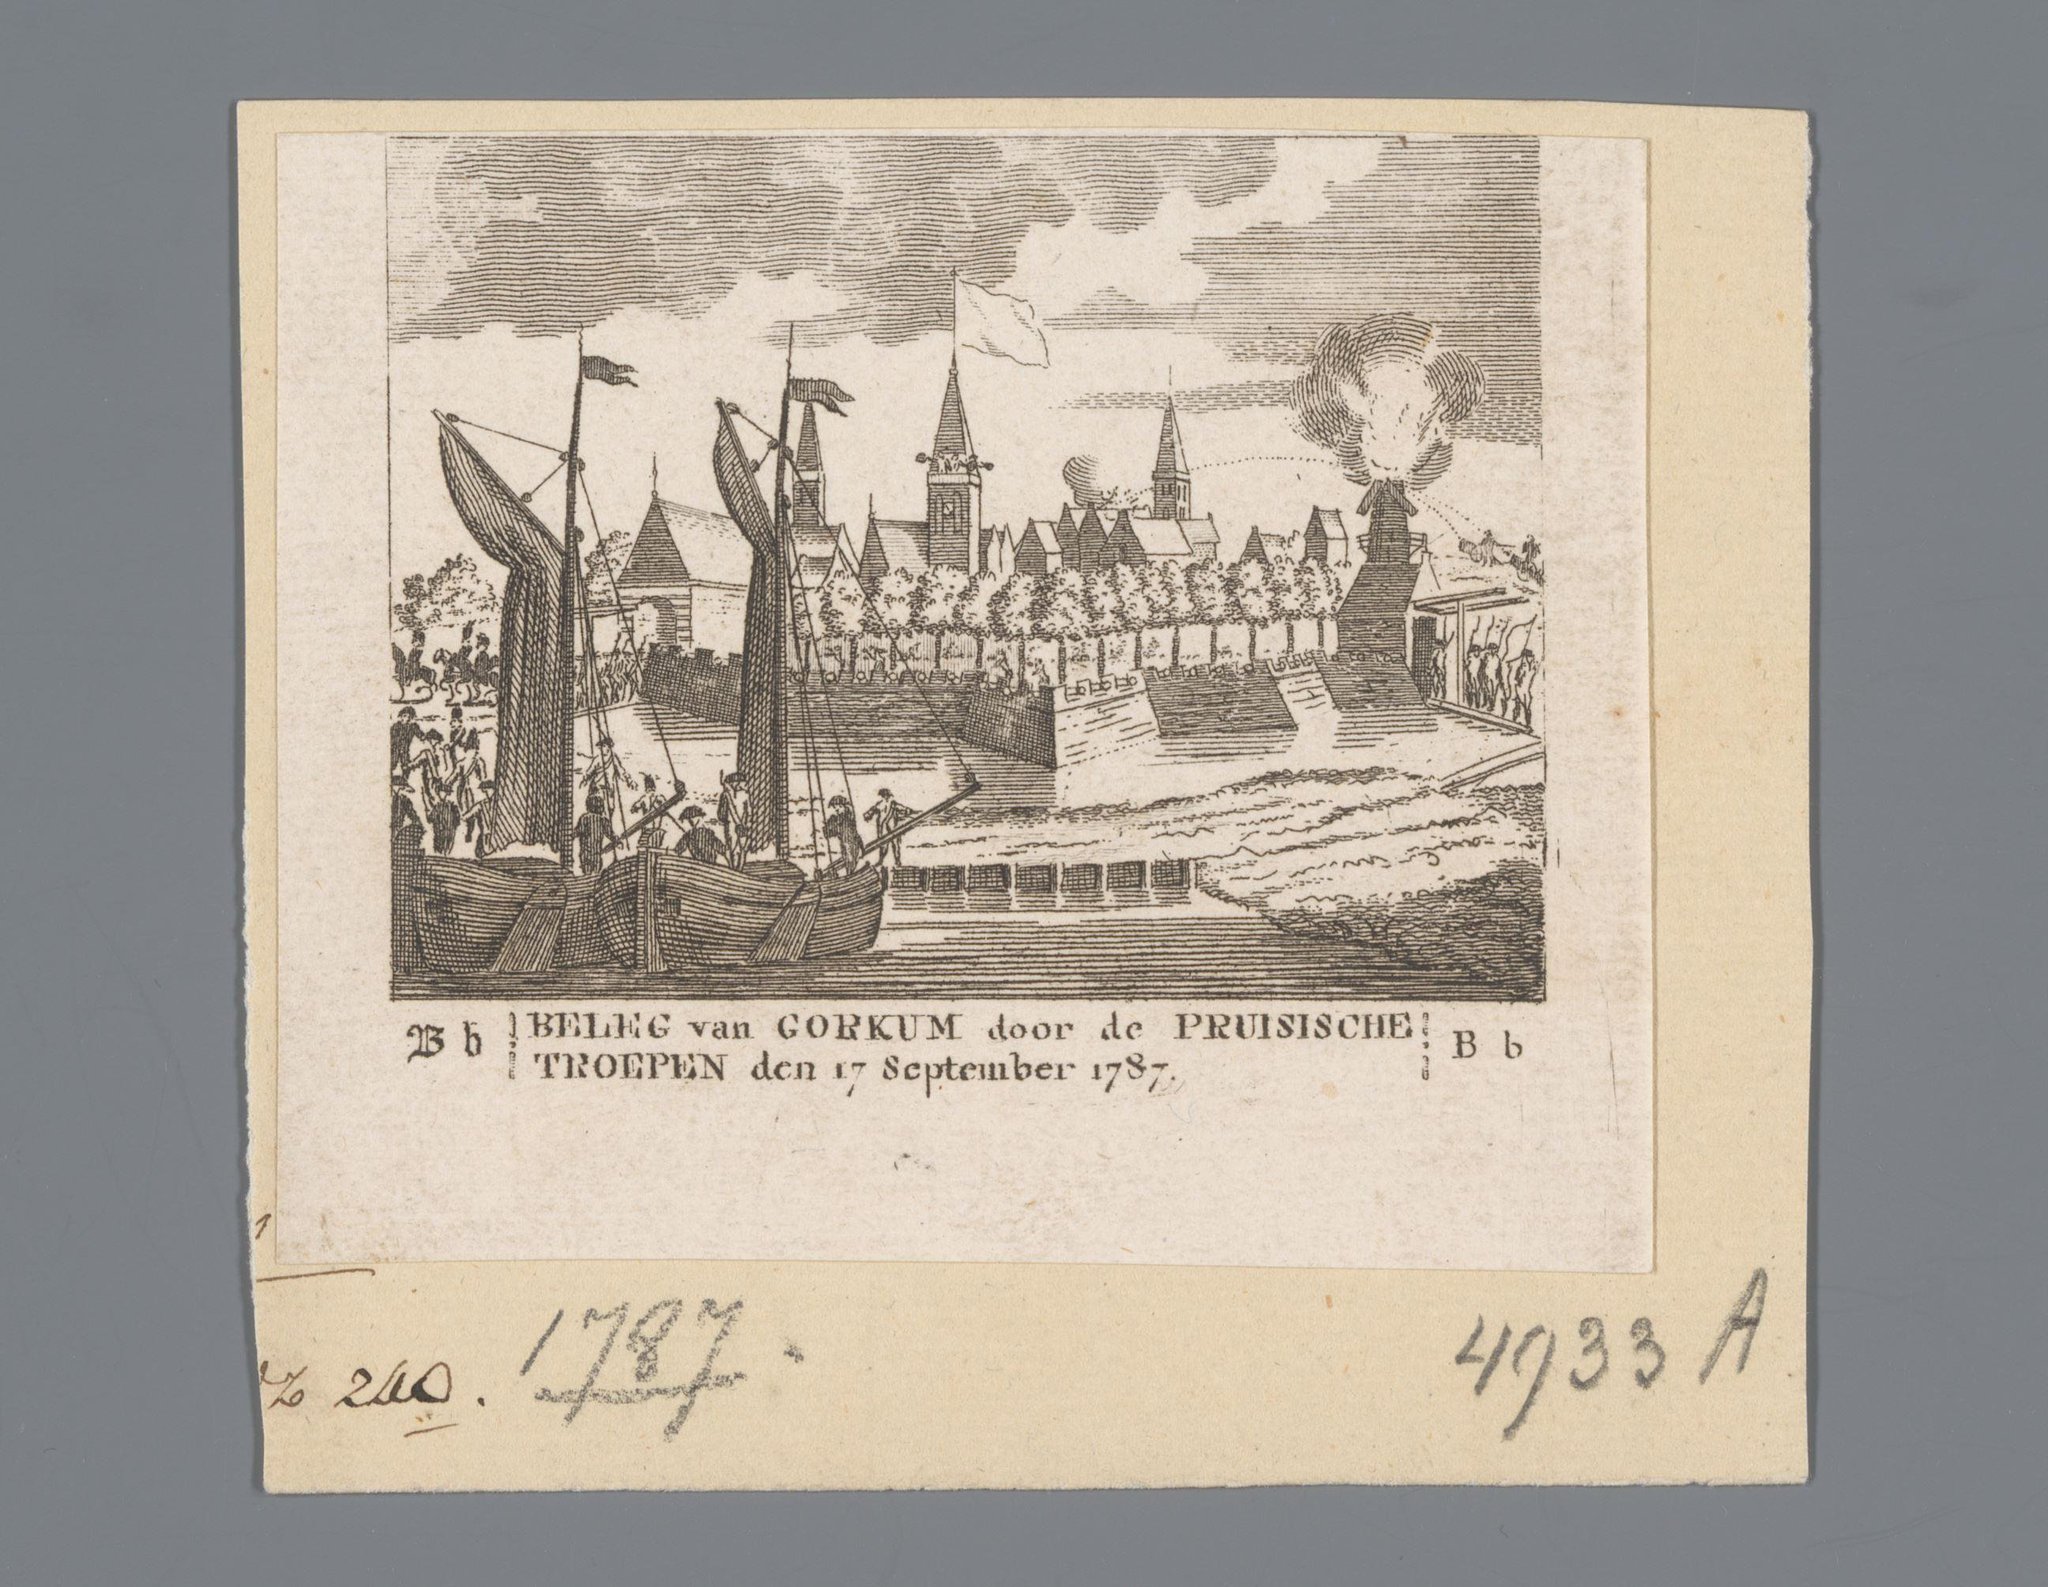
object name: print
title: Beleg van Gorkum door de Pruisische Troepen den 17 September 1787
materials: paper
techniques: etching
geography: amsterdam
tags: putting the enemy to flight - hh - being put to flight, fleeing (+ citizen soldiery, civil guard, citizen militia), siege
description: Prent uit: Vorstelyke Koninglyke en Princelyke Atlas en Dagboek van Nederlandsche gebeurtenisse (...) en oprecht Vaderlandsch, Staats-en stadhouderlyk A.B. Boek (...). Amsterdam, Willem Coertse, [ca. 1790], tussen p. 2 en 3.